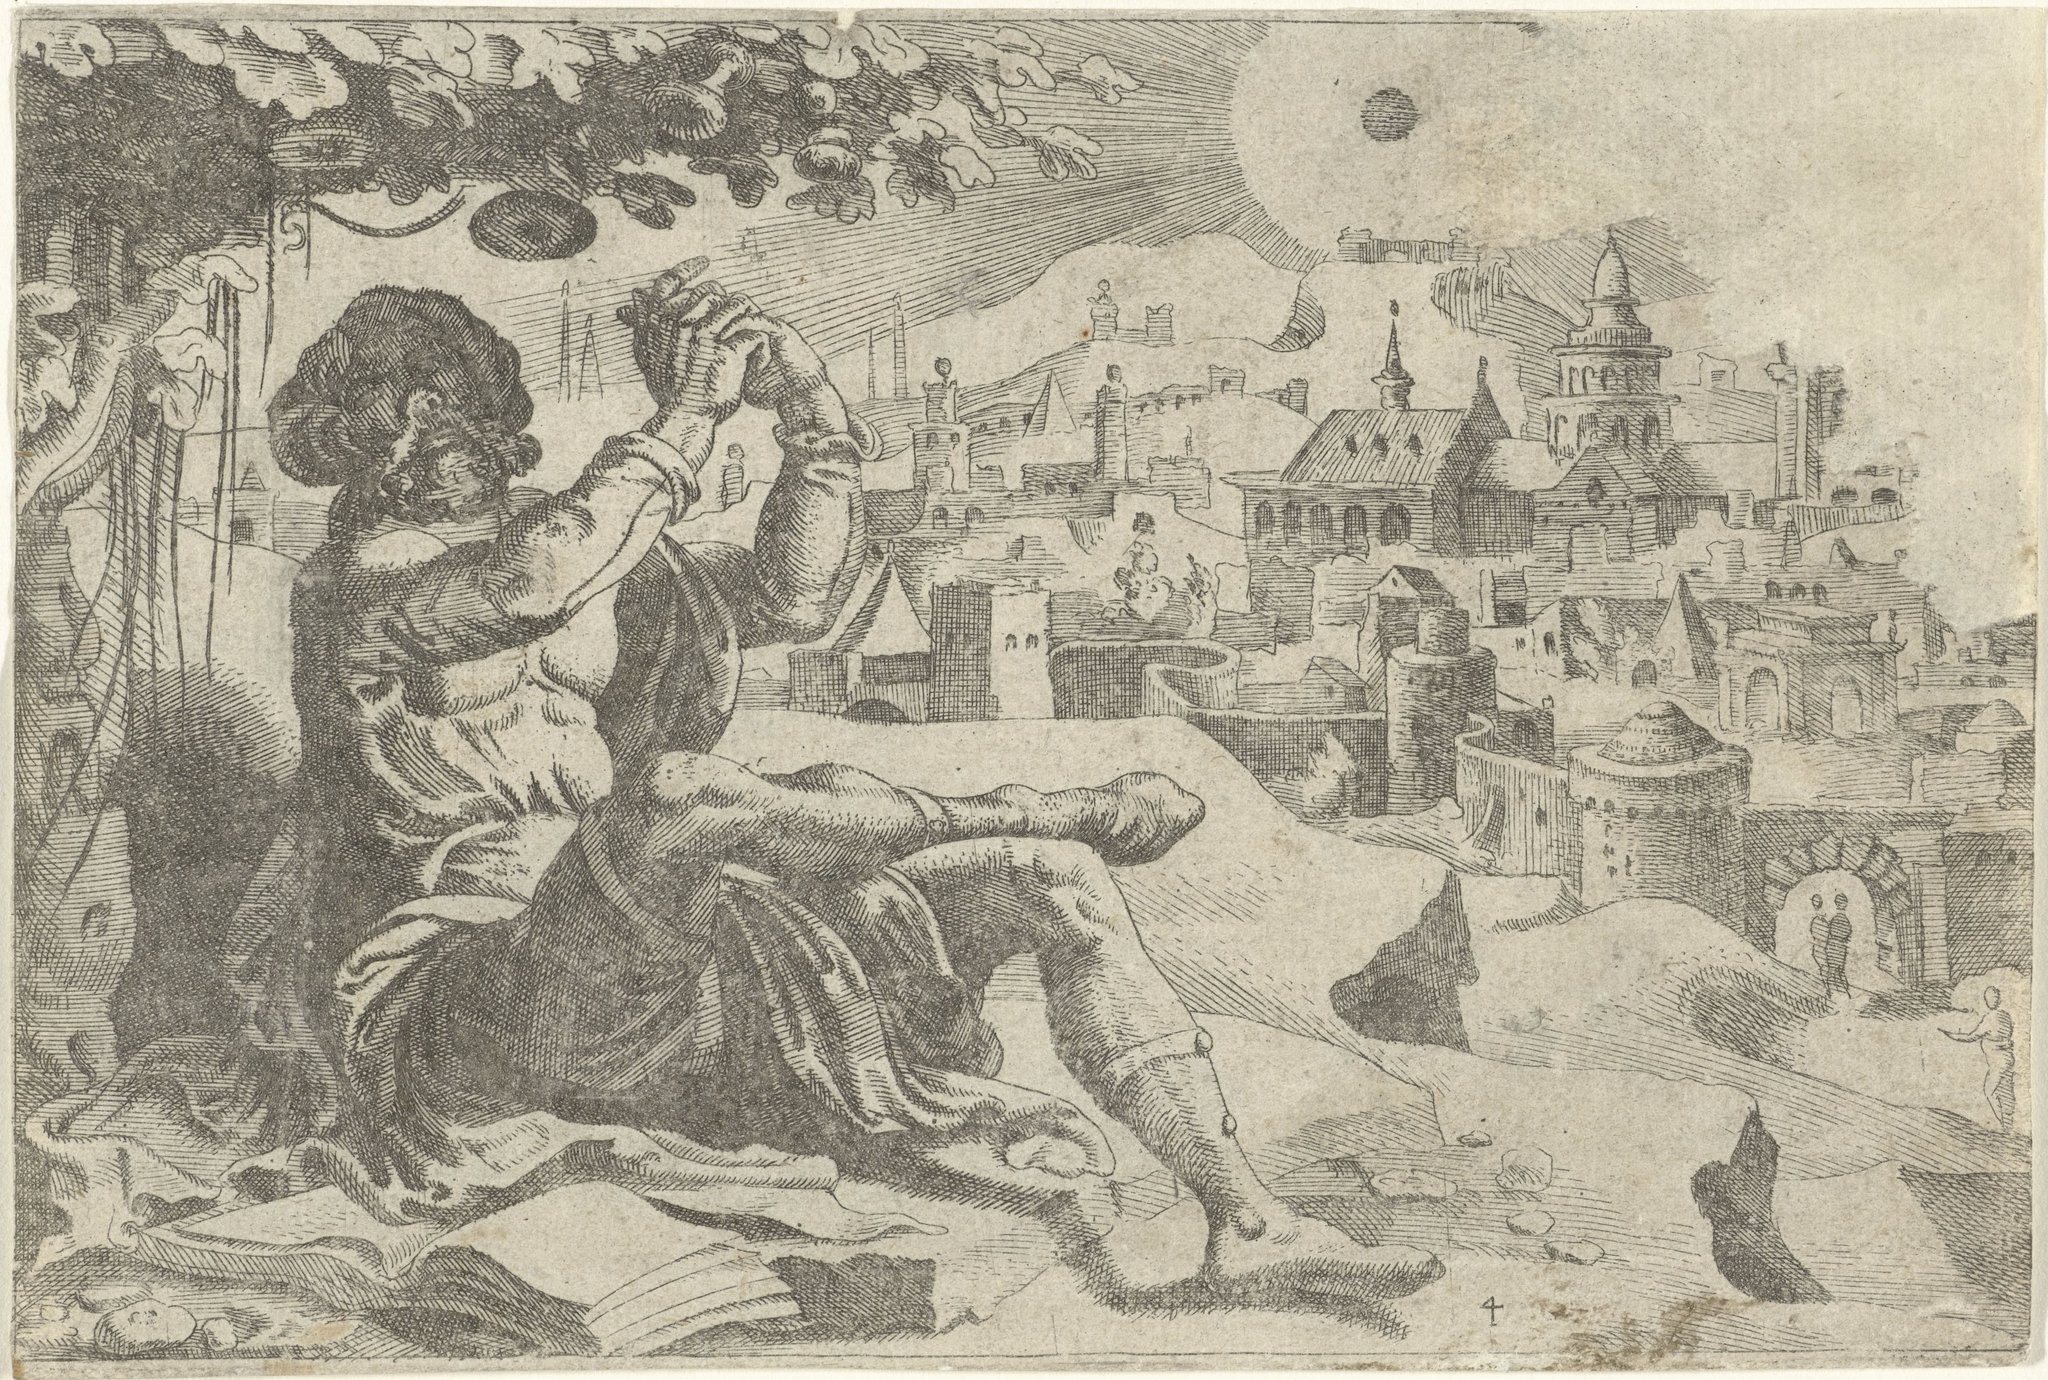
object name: print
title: Geschiedenis van Jona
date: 1548-1552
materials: paper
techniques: etching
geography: haarlem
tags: the prophet jonah withdraws from nineveh; he builds a booth and while enjoying the shade of a plant (gourd or vine) which god made grow for him, he awaits the destiny of the city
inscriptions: collector's mark: Lugt 2228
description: Jona zit onder een boom van kalebassen te lezen. Op de achtergrond de stad Nineve.